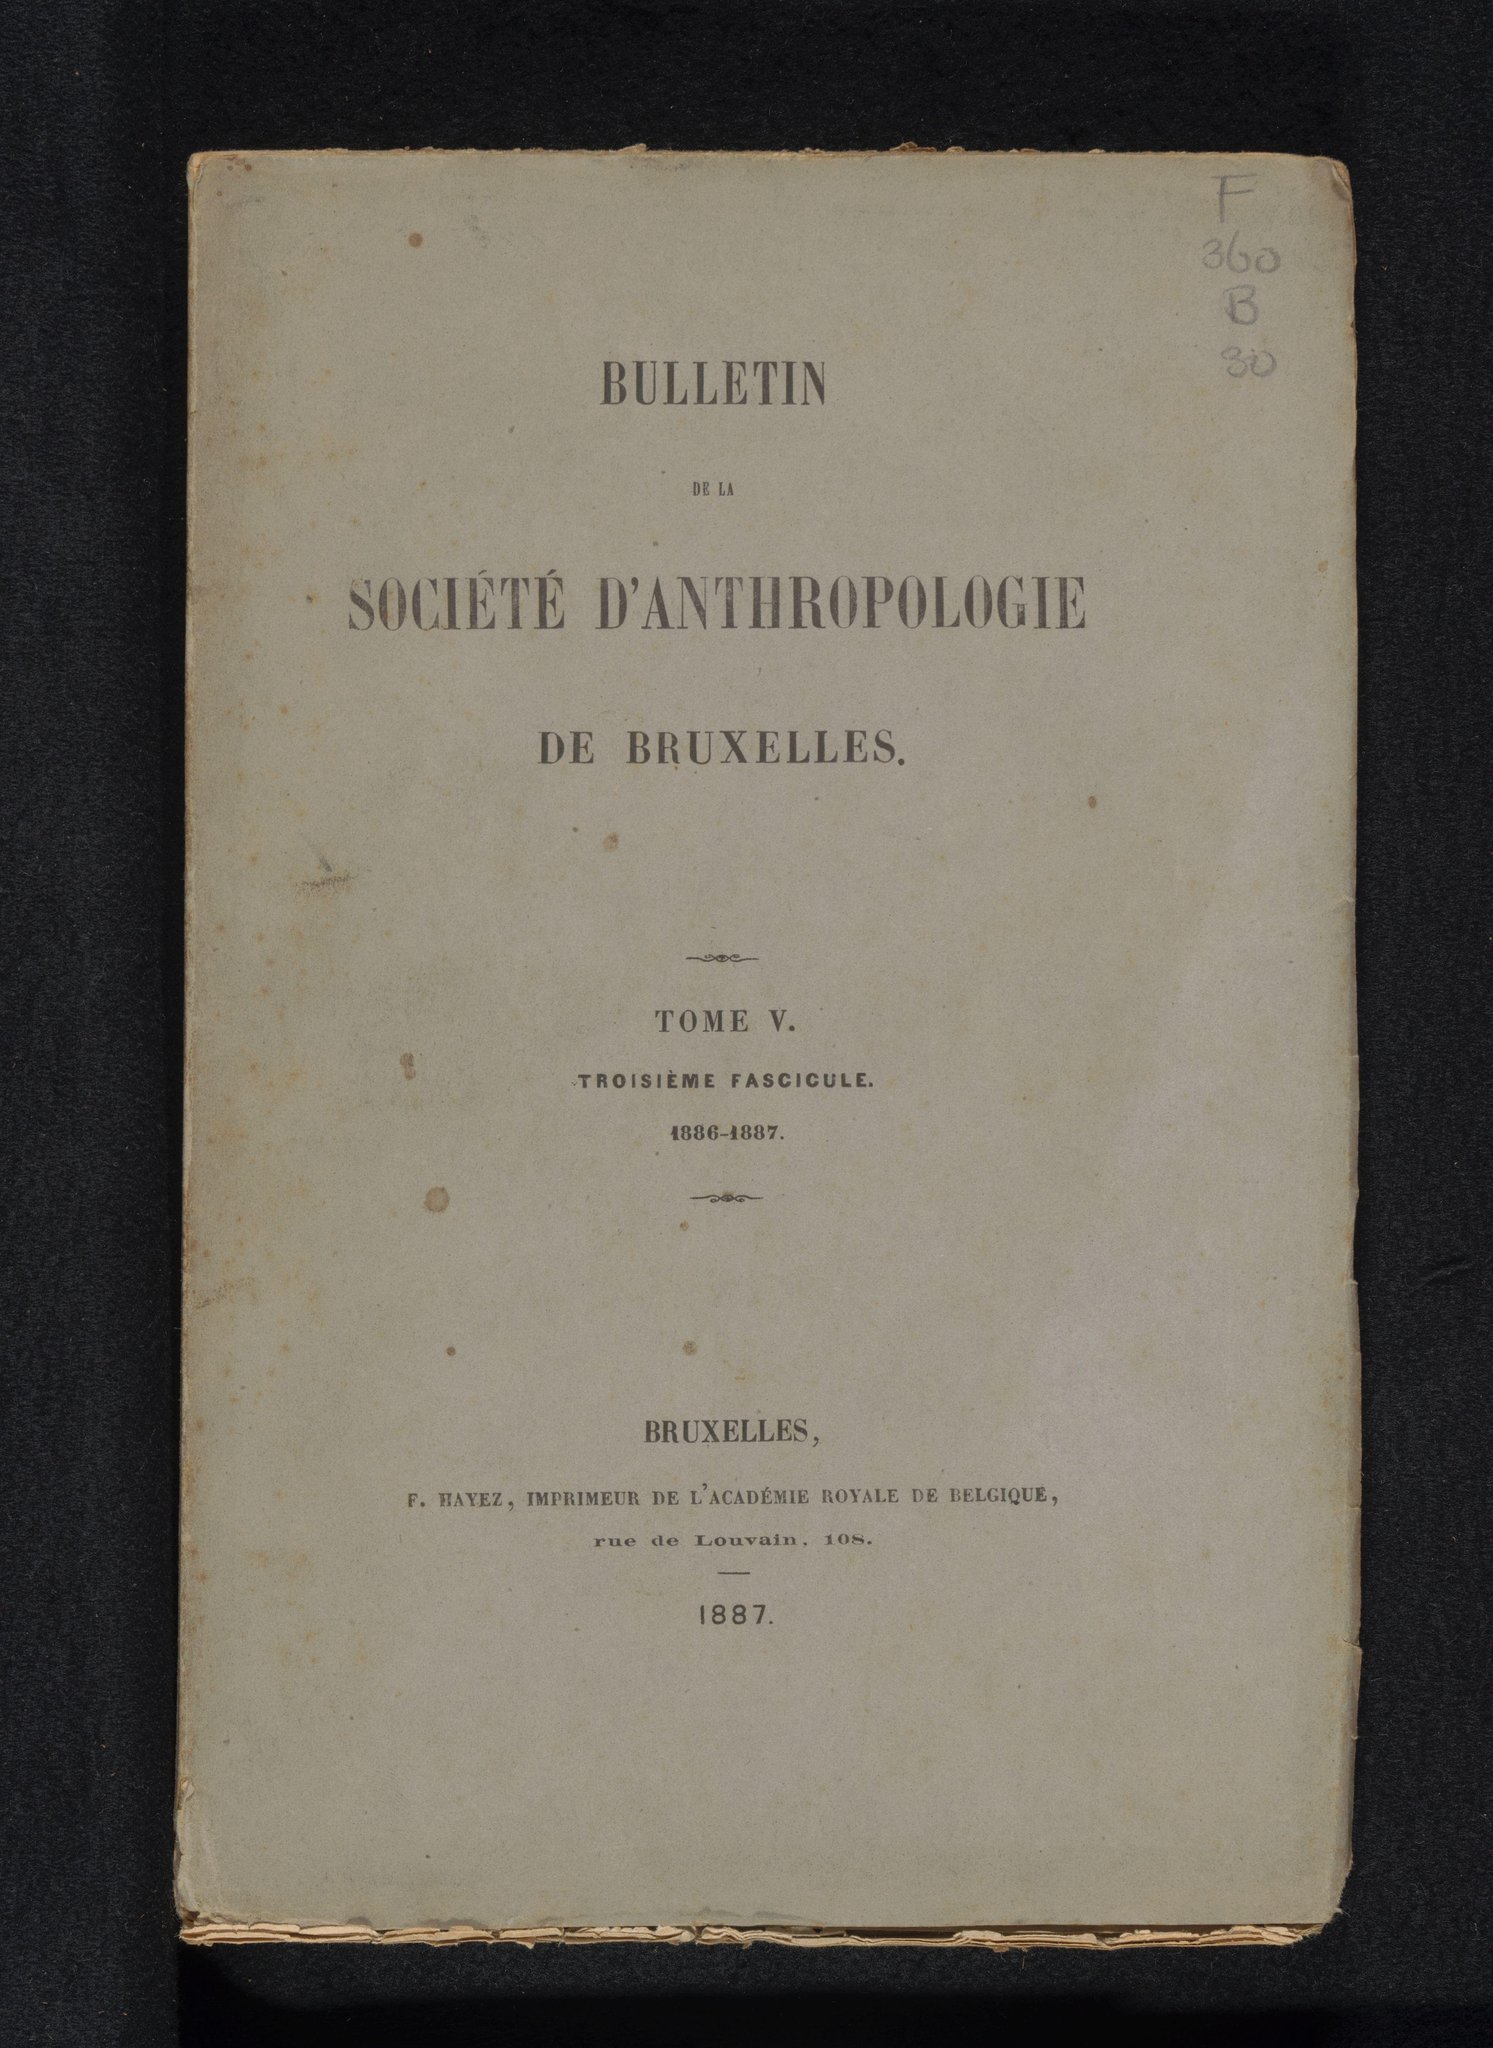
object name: magazine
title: Bulletin de la Société d'anthropologie de Bruxelles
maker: f. hayez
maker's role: printer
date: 1887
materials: paper, textile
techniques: photograph, printing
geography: brussels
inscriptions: annotation: ‘SEPT/ 1997’